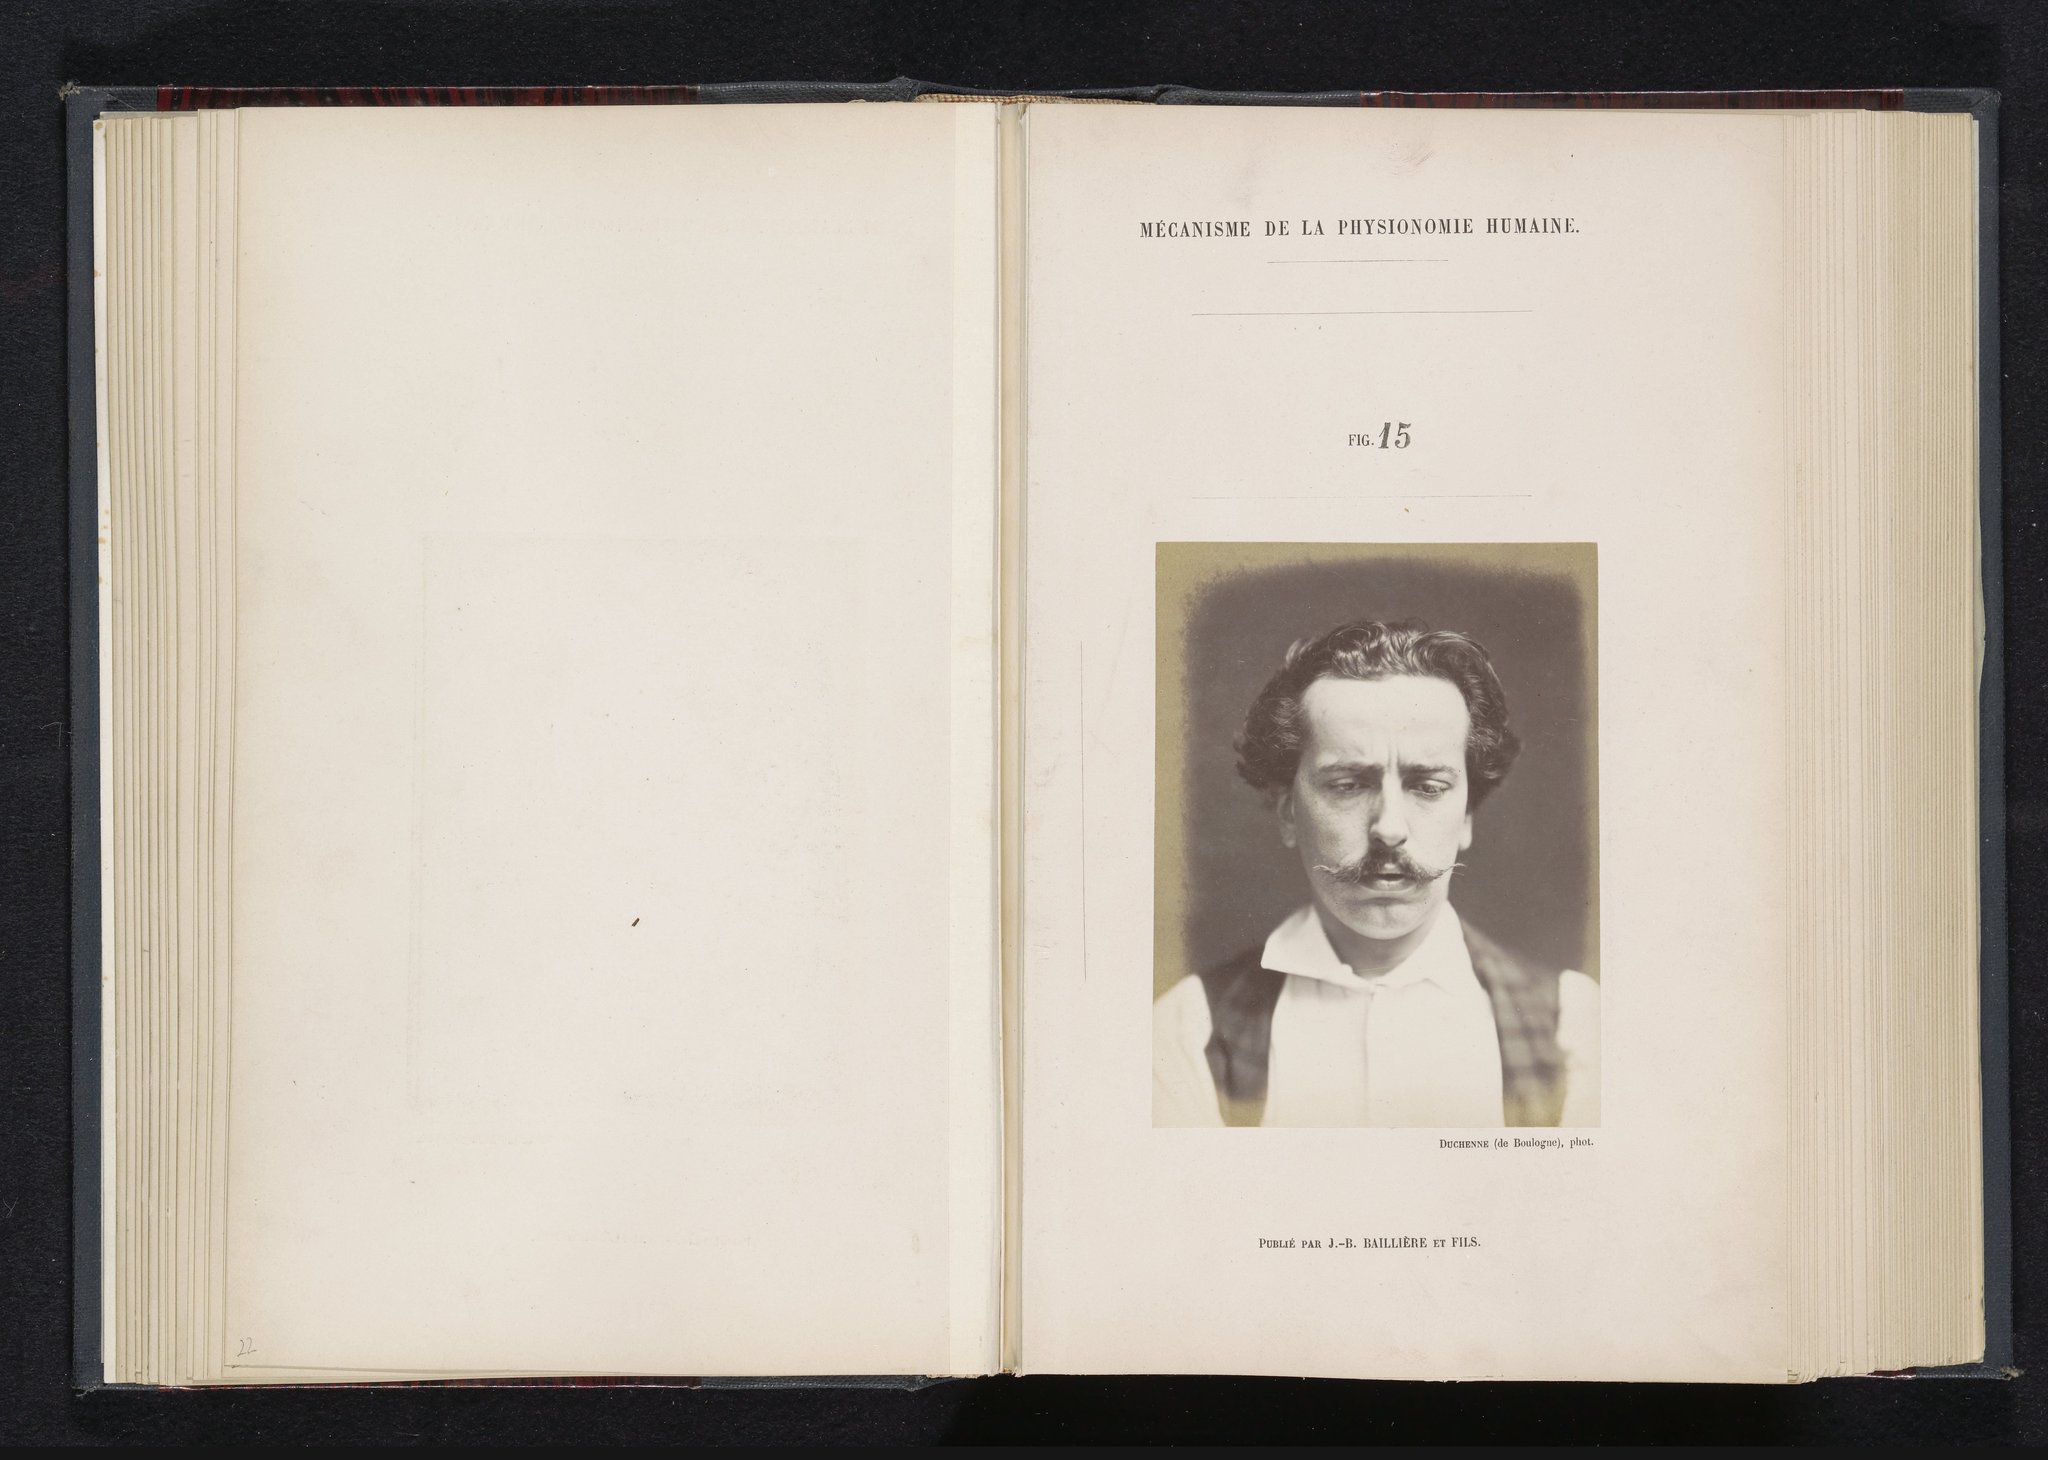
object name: page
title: Portret van een proefpersoon: 'un jeune homme'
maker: guillaume benjamin amand duchenne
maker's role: fotograaf, medicus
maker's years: 1806-1875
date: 1860-1862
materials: paper, photographic support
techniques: albumen print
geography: paris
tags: face, physiology and anatomy ~ nervous system, neurology, adult man, physiology and anatomy, morphology of facial expression, physiognomy, experiment, test ~ science and technology, france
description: Ongenummerde pagina met foto 15 uit Mécanisme de la physionomie humaine ou analyse électro-physiologique de l'expression des passions (Atlas).